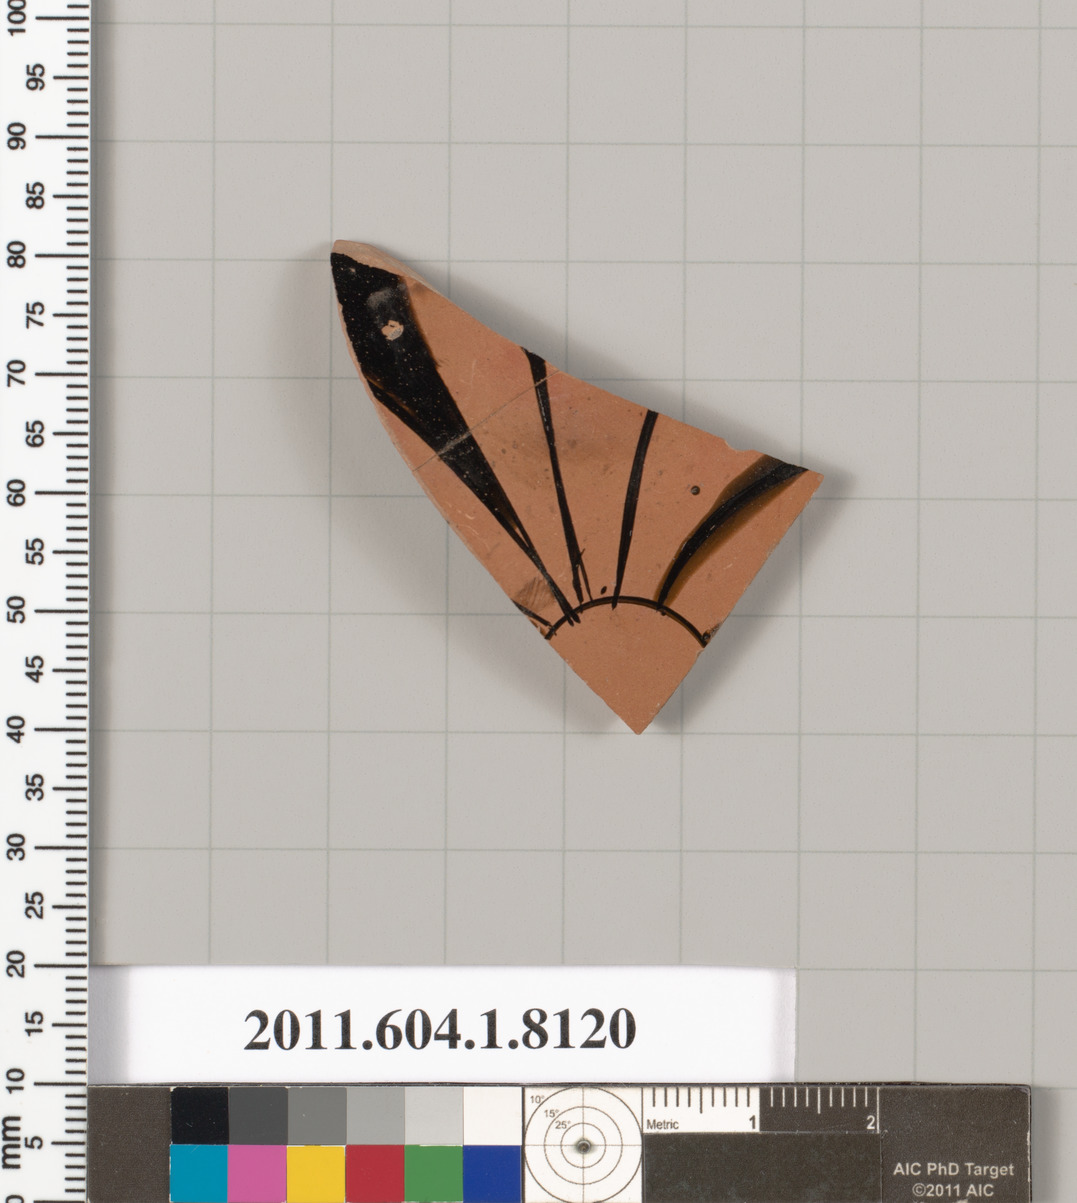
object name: kylix fragment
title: Terracotta fragment of a kylix (drinking cup)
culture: greek, attic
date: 534-468 BCE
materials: terracotta